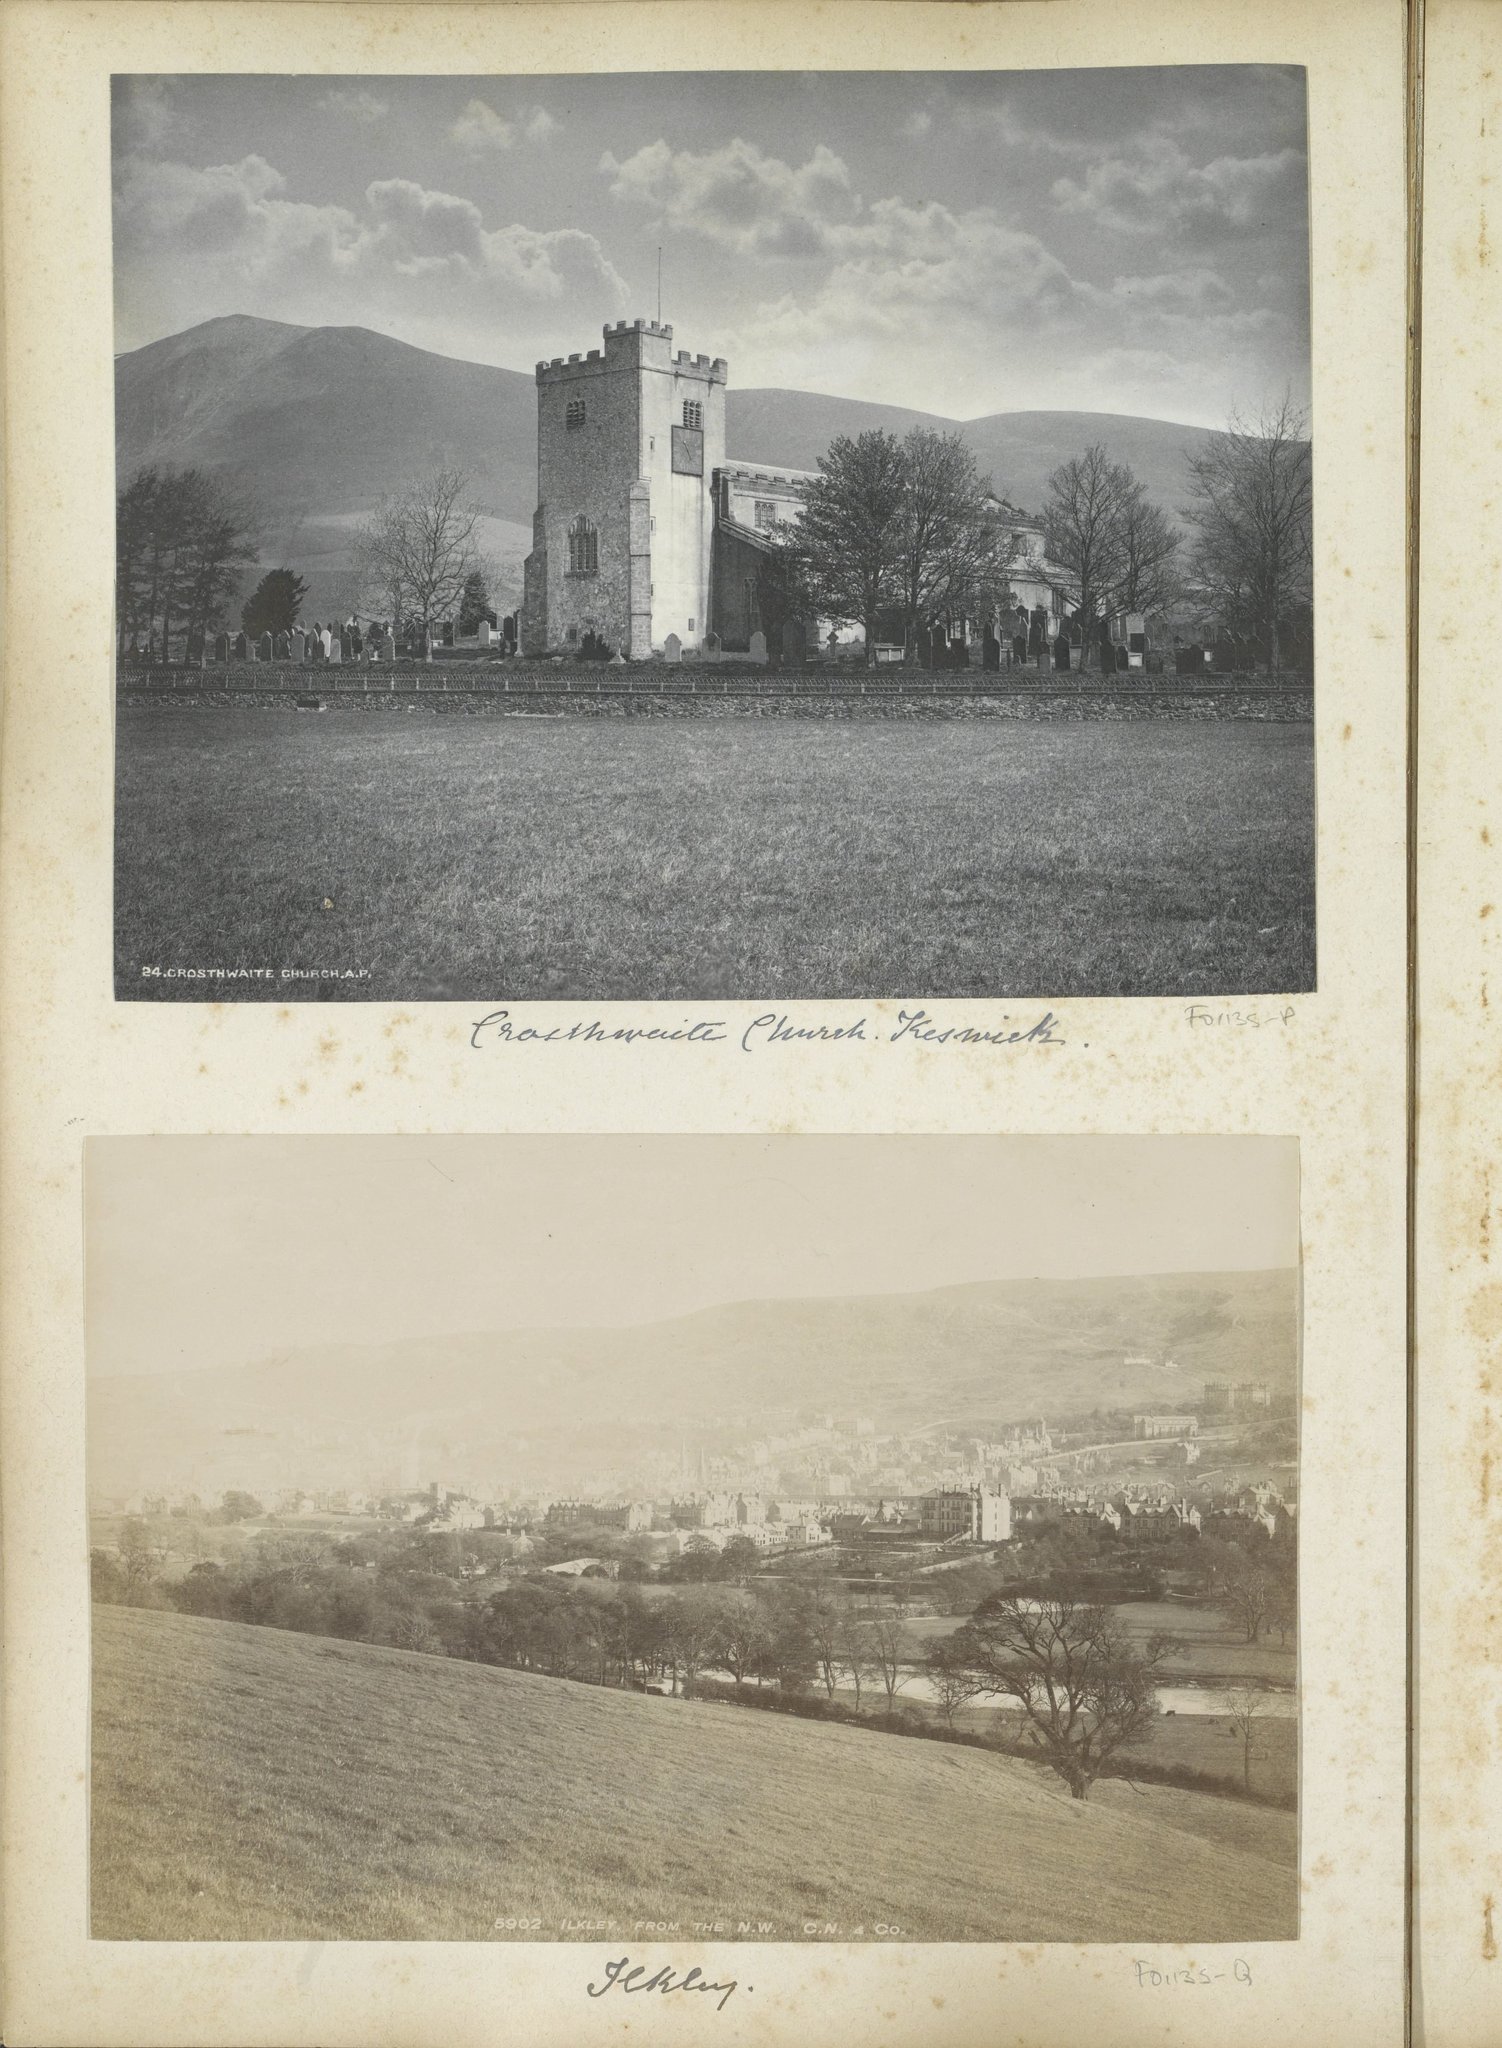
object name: photograph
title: Crosthwaite Church. A.P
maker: monogrammist ap (fotograaf)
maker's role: fotograaf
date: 1898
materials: paper, photographic support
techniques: platinum process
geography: keswick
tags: church (exterior), churchyard, cemetery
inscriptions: number: ‘24’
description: Onderdeel van Reisalbum met foto's van bezienswaardigheden in Engeland en Frankrijk.